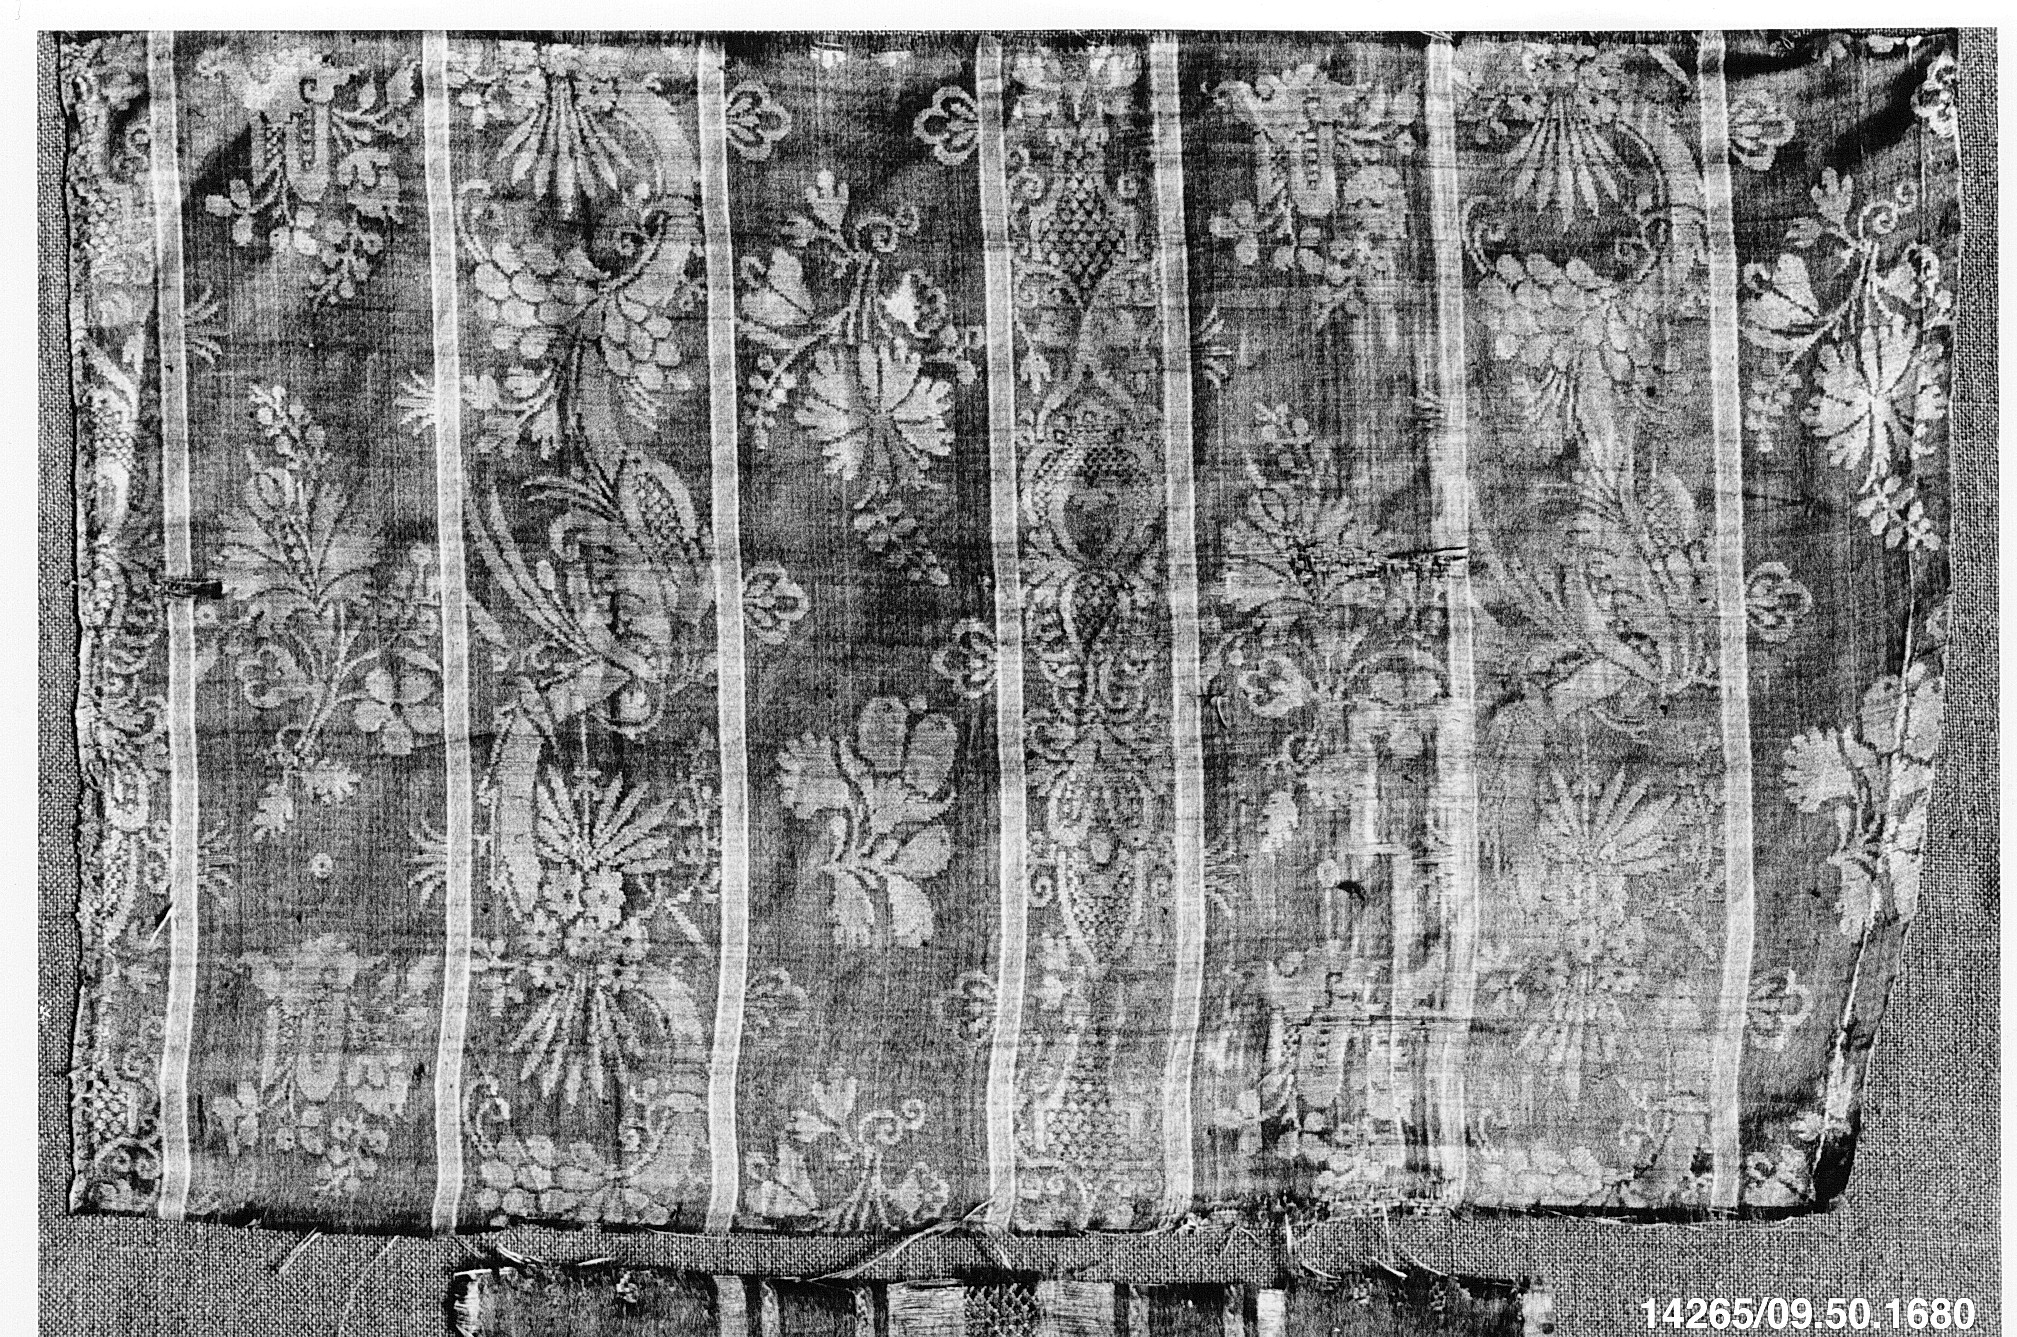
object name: piece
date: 1667-1733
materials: linen, silk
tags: flowers,leaves